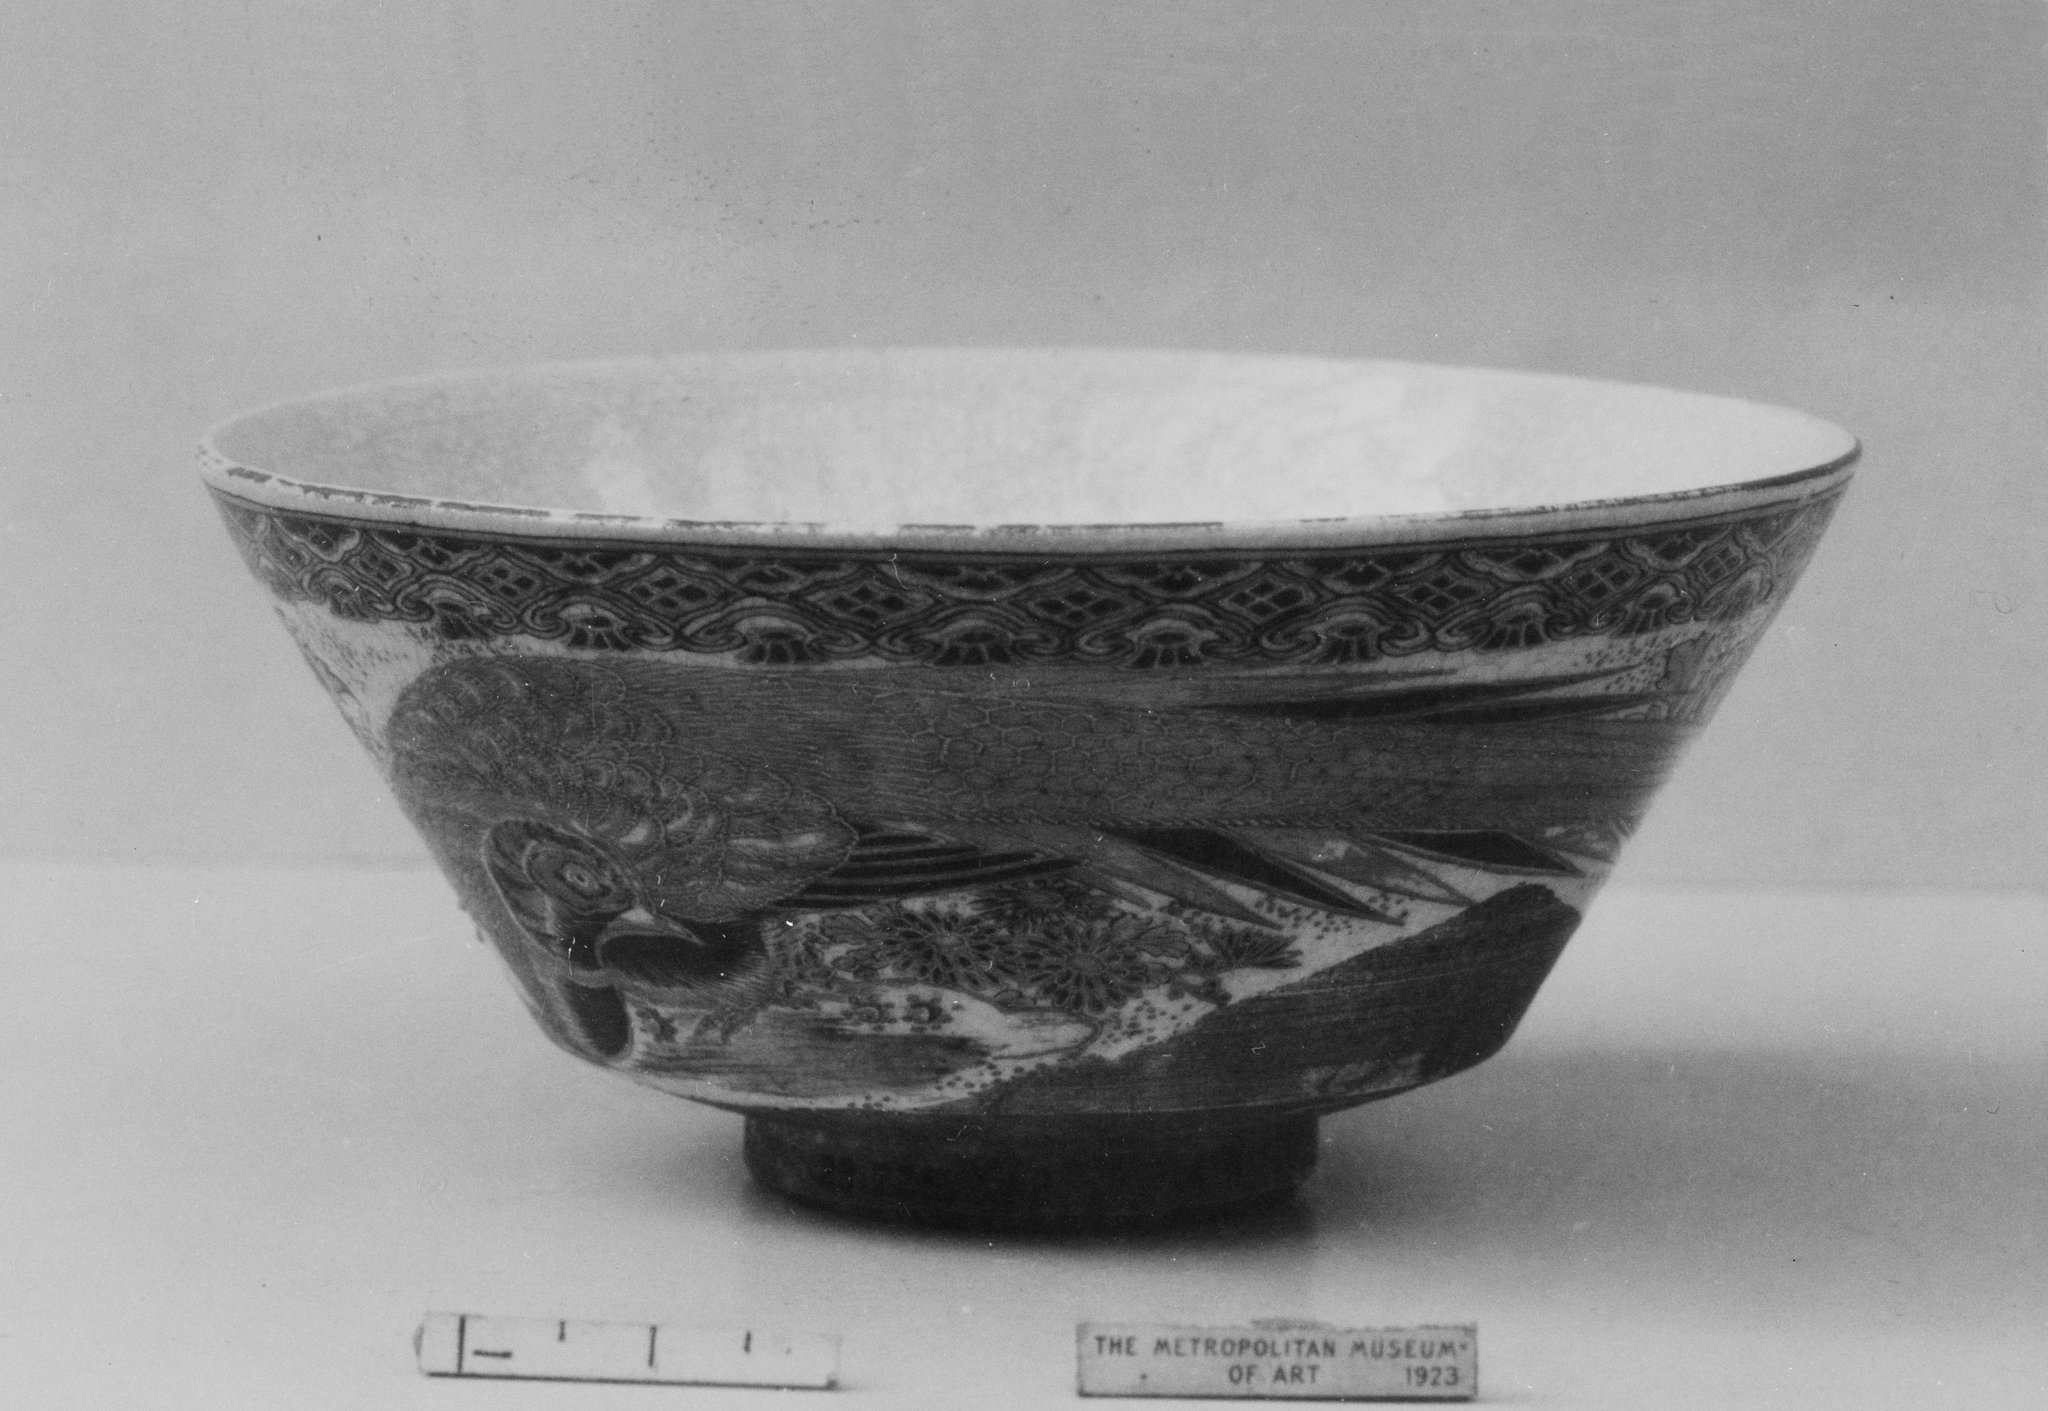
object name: bowl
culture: japanese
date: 1820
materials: enamel, faience